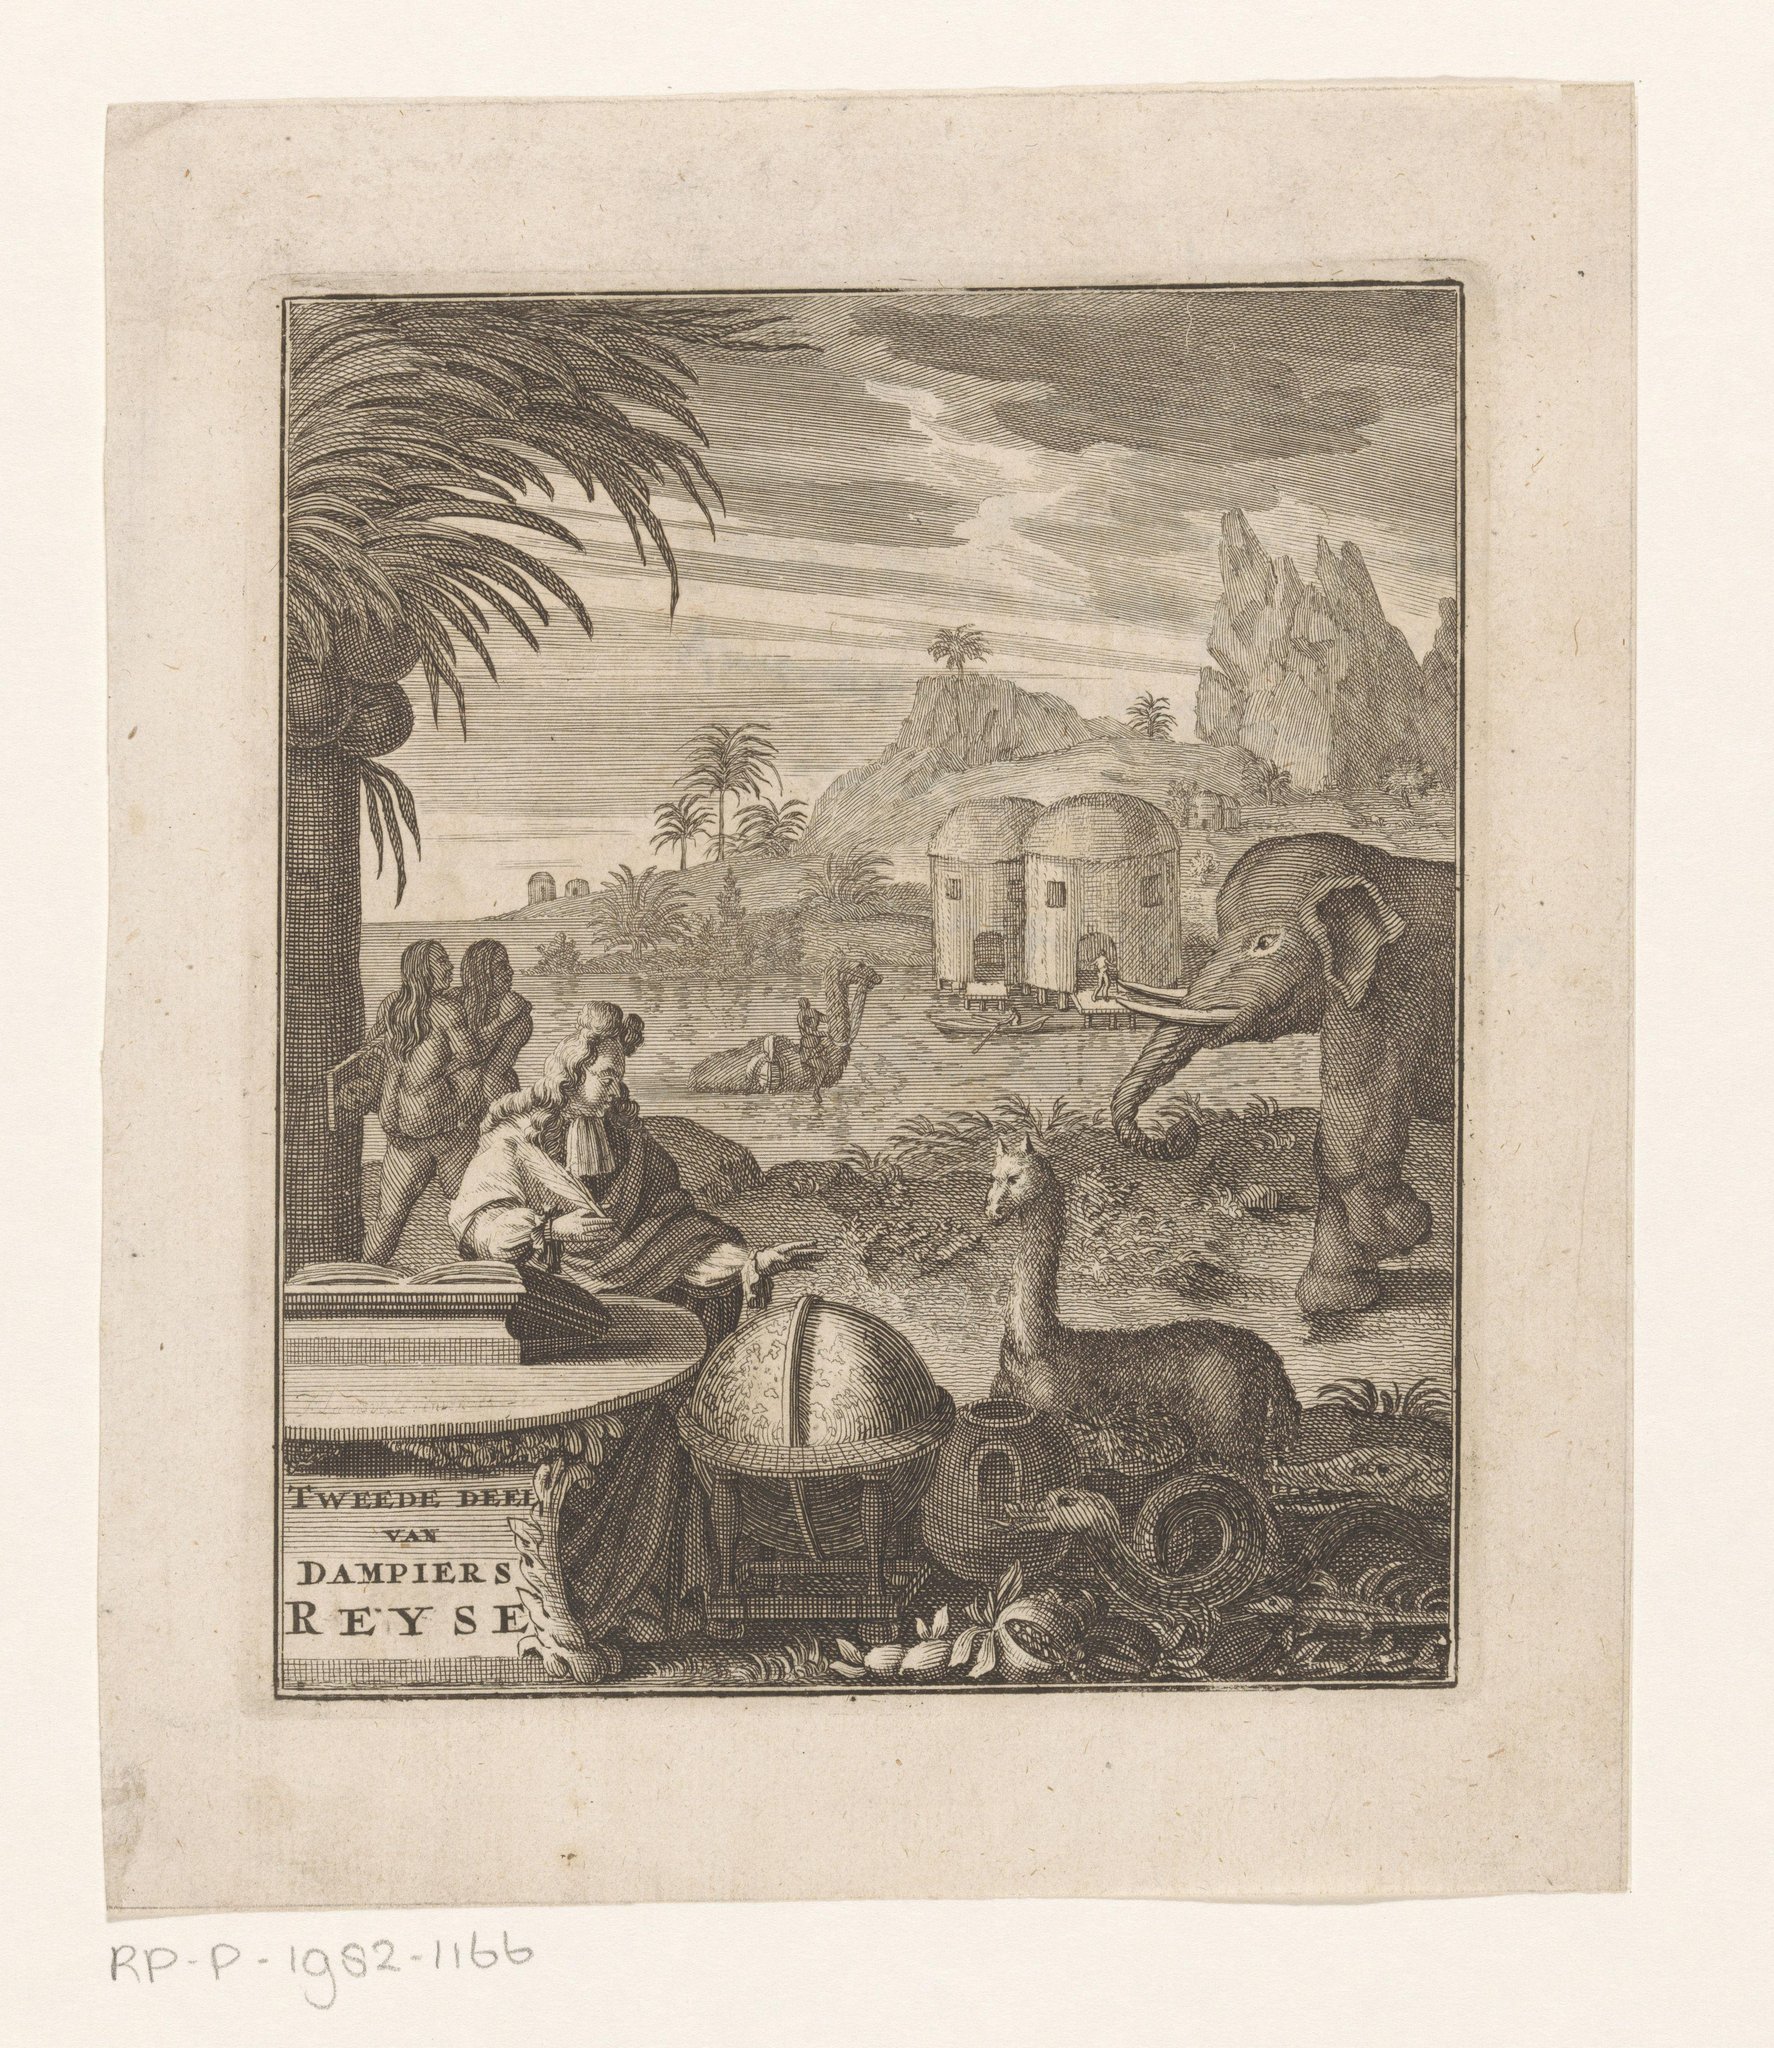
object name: titelblad, titelpagina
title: Titelpagina voor: William Dampier, Tweede deel van William Dampiers Reystogt rondom de werreld, 1700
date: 1700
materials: paper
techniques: etching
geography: the hague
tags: landscapes in the non-temperate zone, exotic landscapes, exploration, expedition, voyage of discovery, globe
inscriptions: collector's mark: Lugt 2228, collector's mark: Lugt 2760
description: Onder een palmboom zit een man, mogelijk William Dampier, met een schrijfveer achter een open boek en bestudeert een globe. Bij hem bevinden zich een slang, een lama en een olifant. In de achtergrond een landschap met woningen en mensen die hij tegenkwam op zijn reizen.